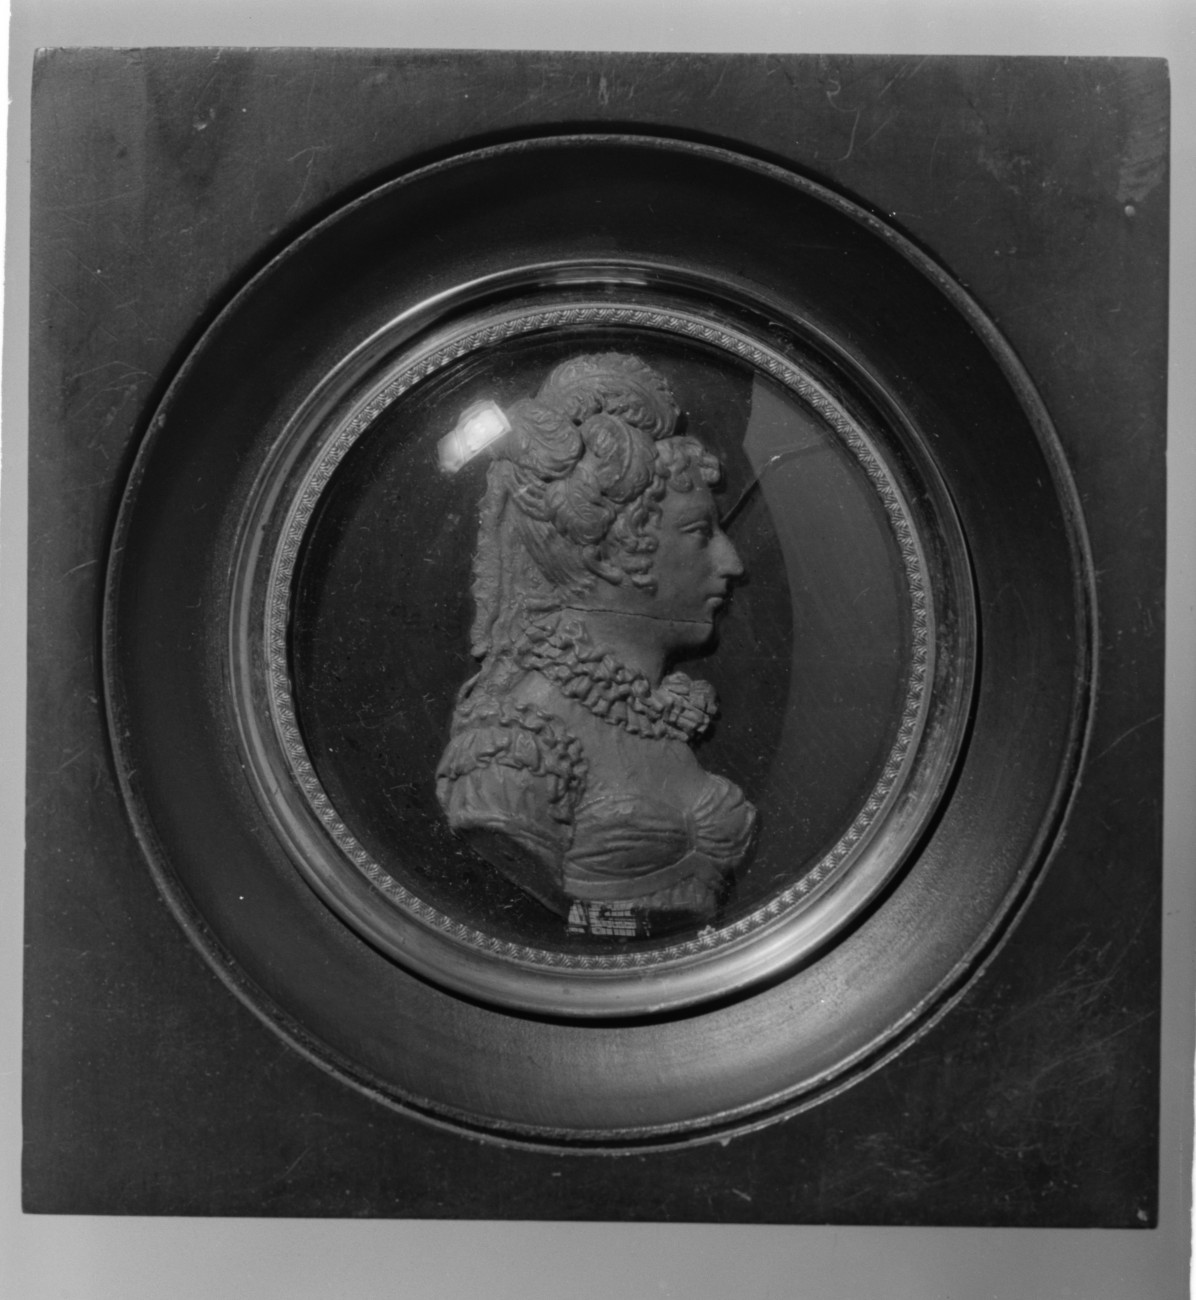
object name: medallion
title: Marie Thérèse Charlotte, Duchesse d'Angoulême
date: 1801-1900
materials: glass, wax, wood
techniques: painting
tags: profiles,women